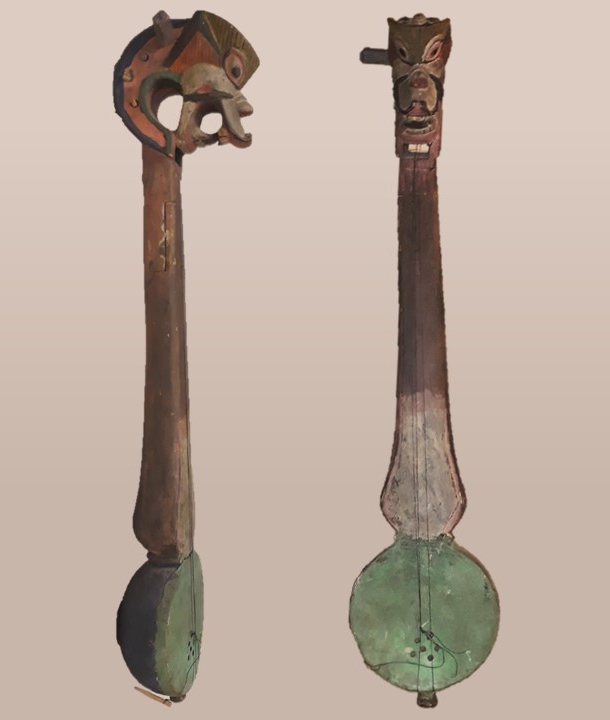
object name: sgra snyan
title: Sgra-Snyan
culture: nepalese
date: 1801-1900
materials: wood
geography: tibet